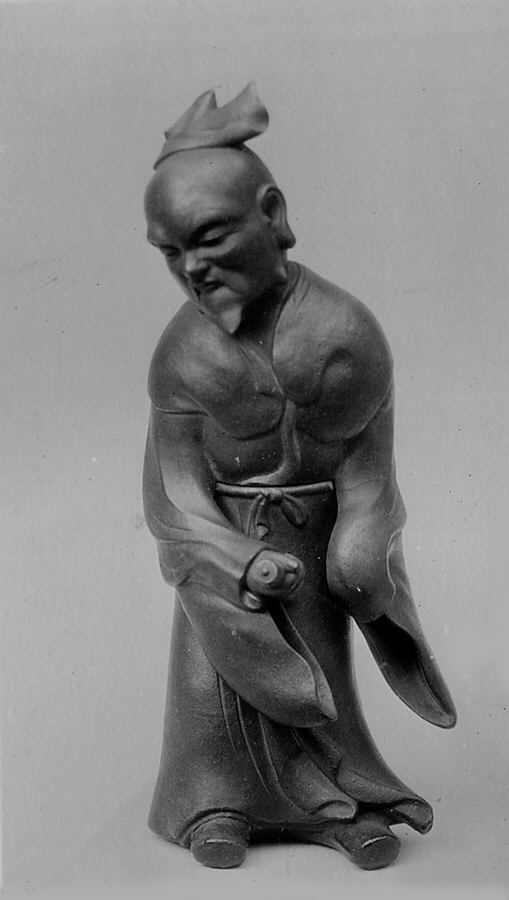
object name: figure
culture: japanese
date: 1780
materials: glaze, stoneware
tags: men